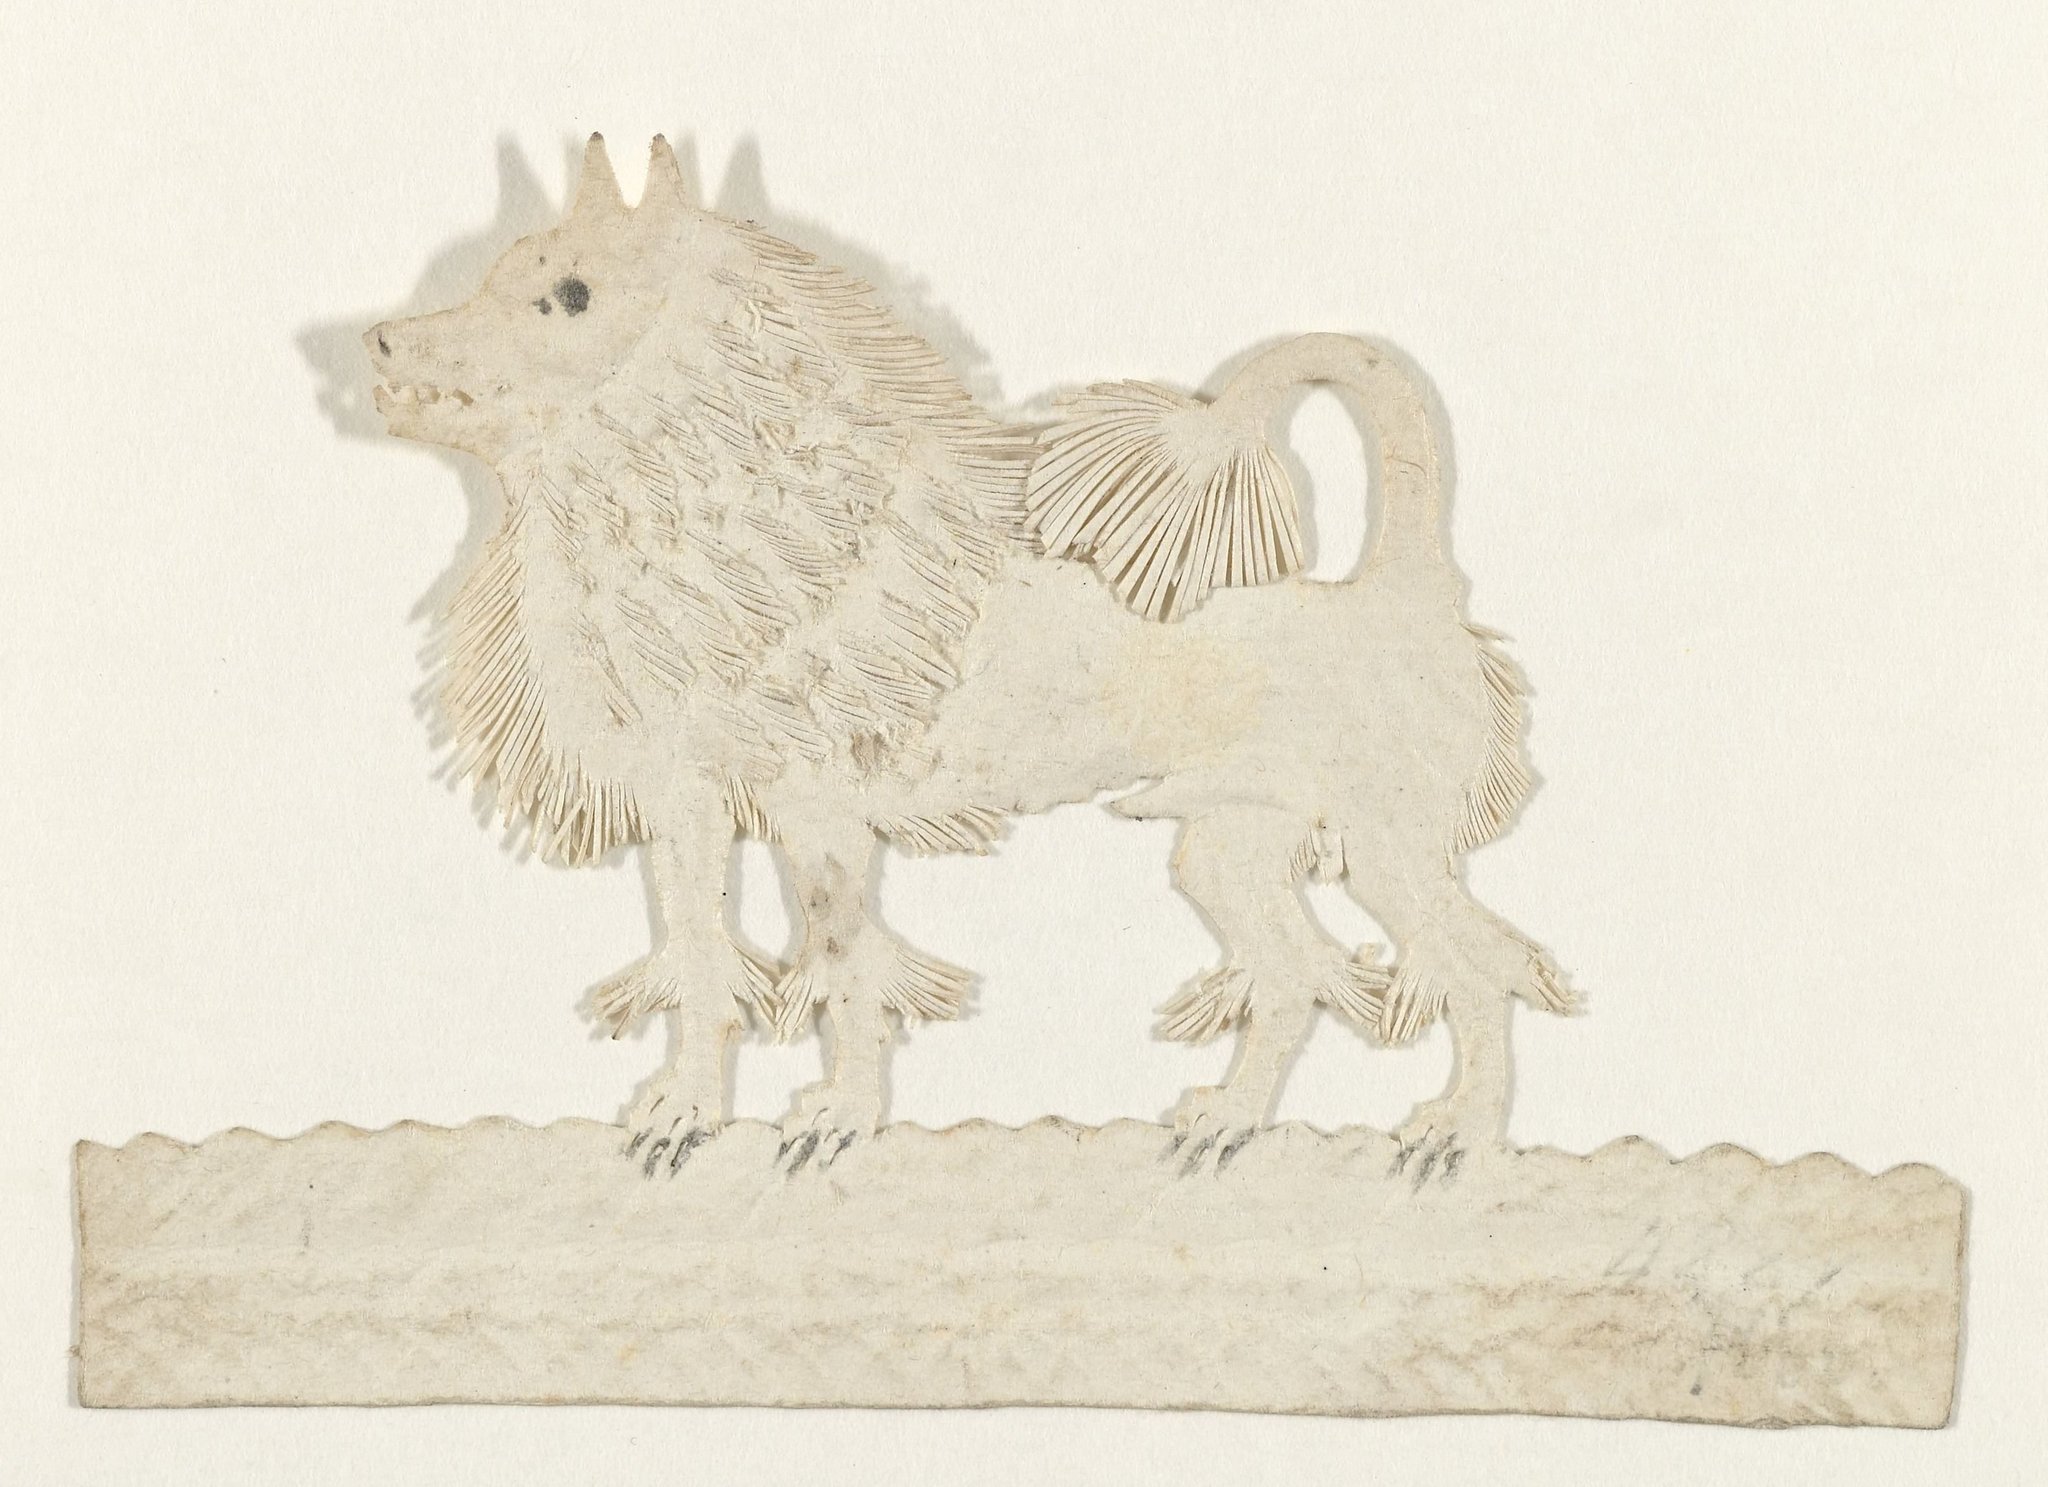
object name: cut paper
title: Keeshond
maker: Anonymous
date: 1787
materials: paper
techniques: snipping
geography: northern netherlands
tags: dog, patriots (1780-1795)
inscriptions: collector's mark: Lugt 2228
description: Knipkunstwerk van een keeshond (patriot) uit wit papier, uit de Patriottentijd.